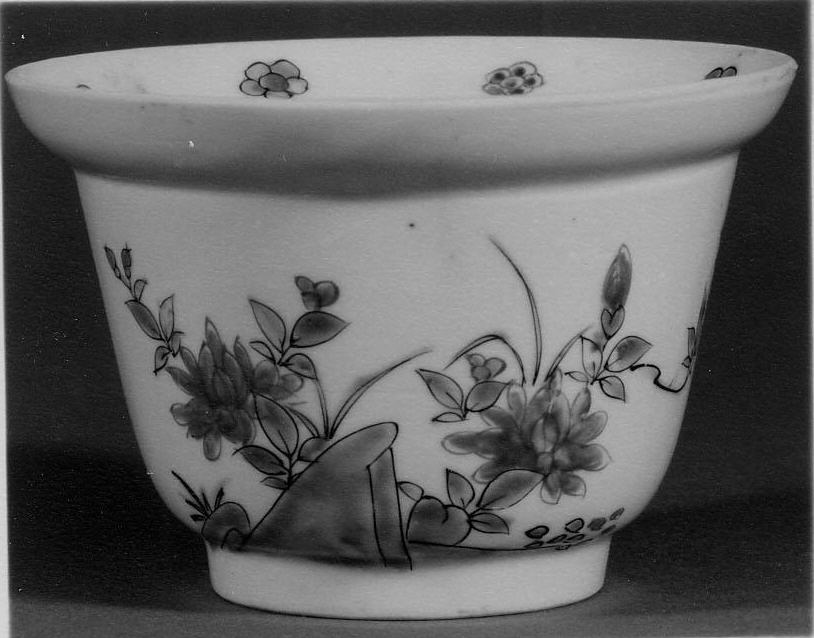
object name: cup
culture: japanese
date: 1601-1700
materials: enamel, porcelain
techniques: overglaze, painting, polychrome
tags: flowers